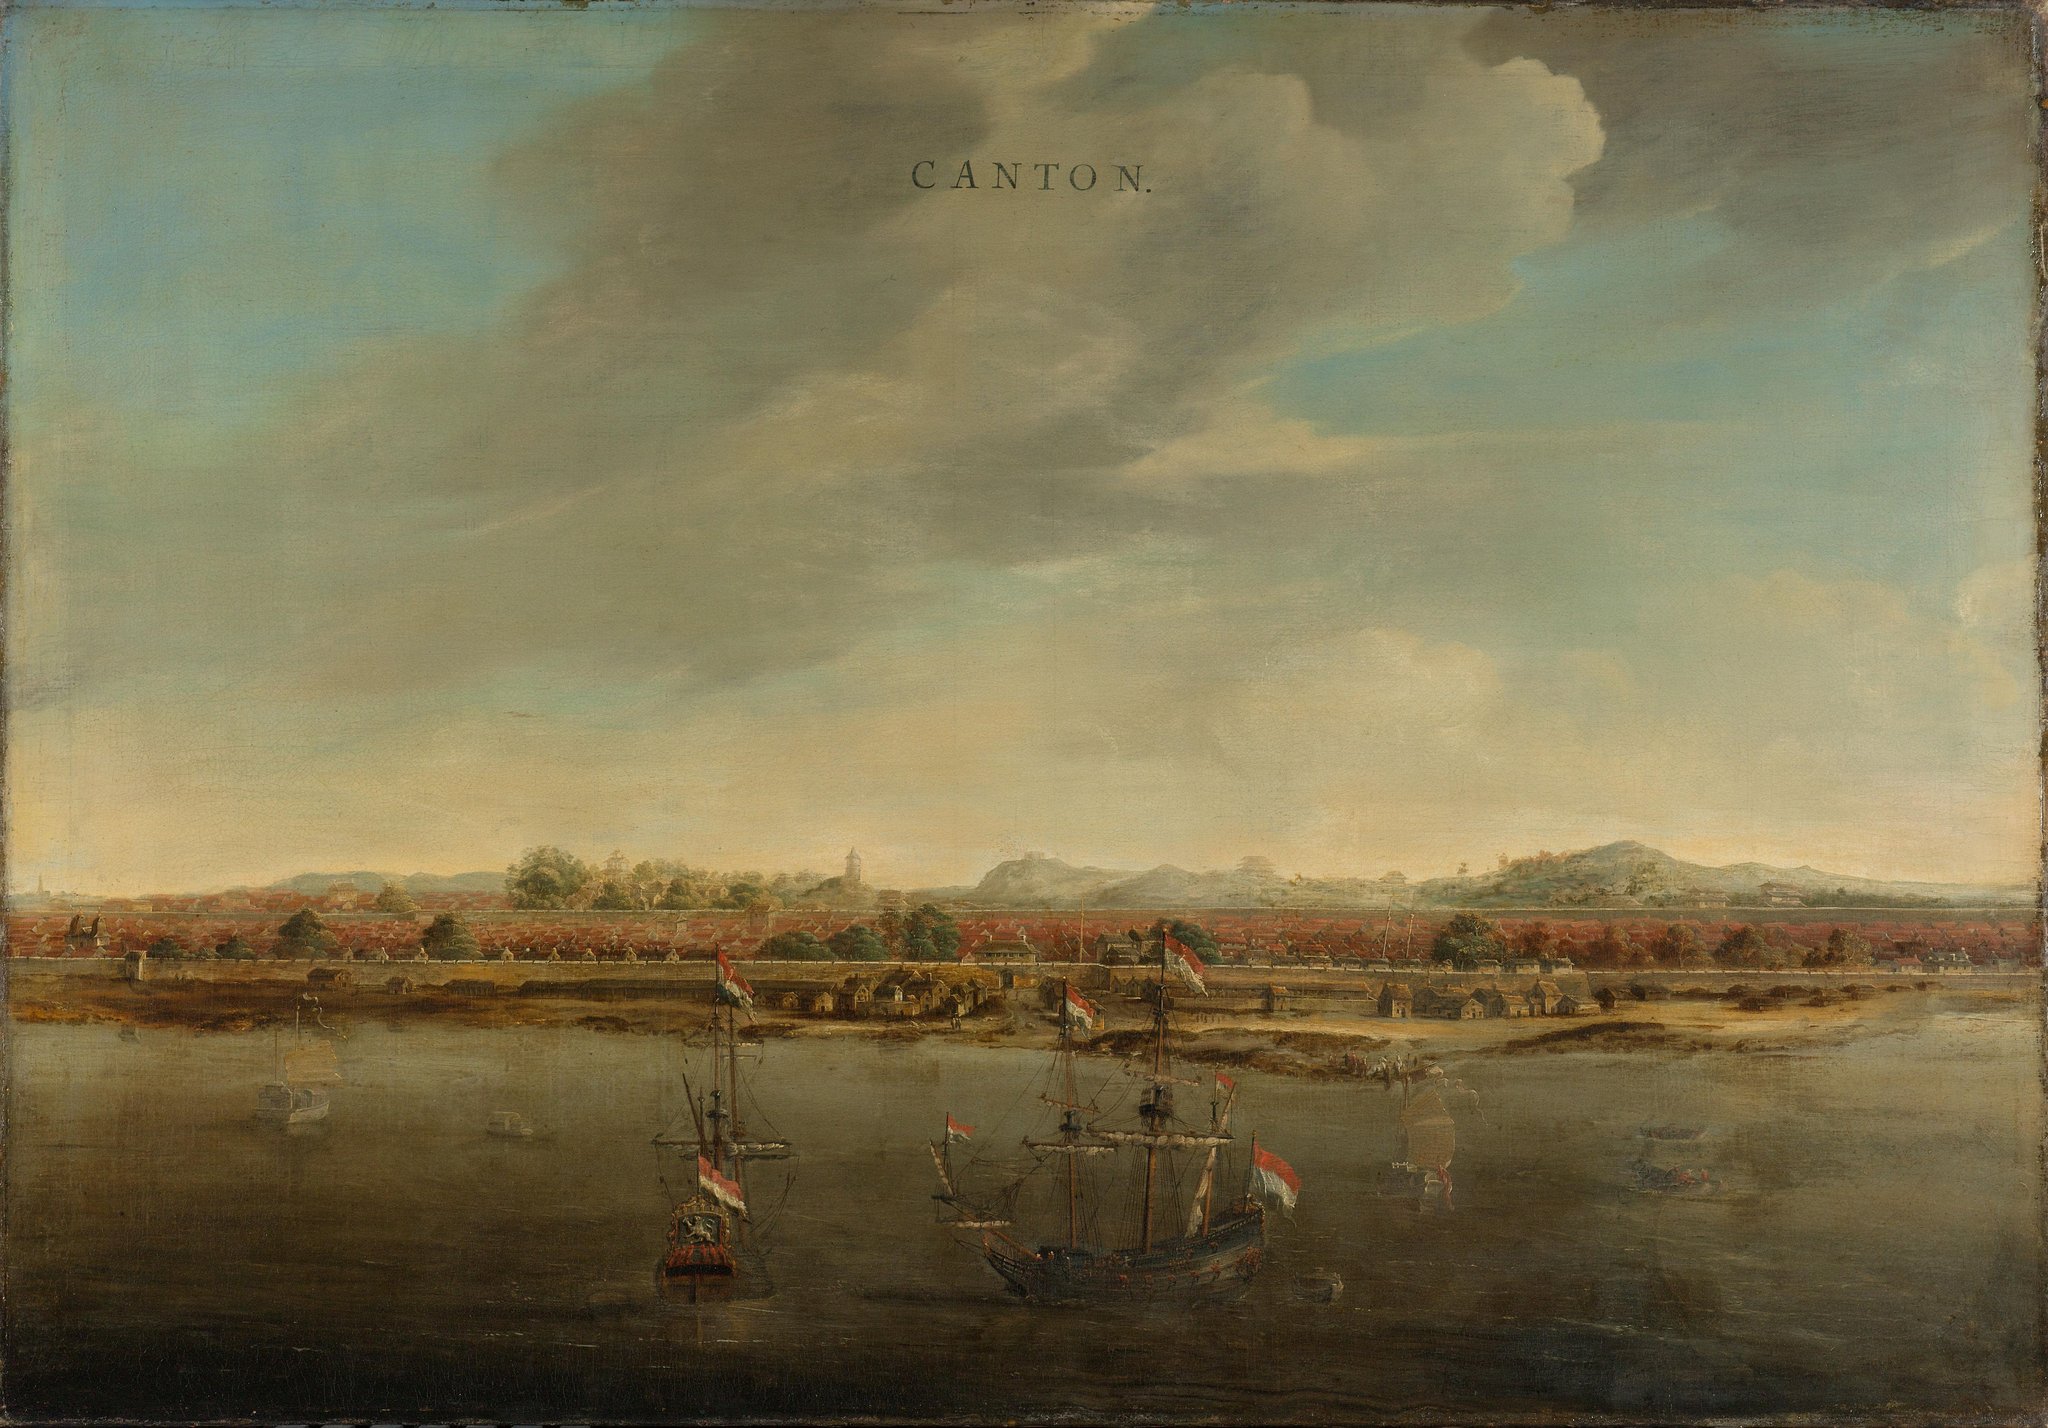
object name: painting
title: Trading posts of the Dutch East India Company (VOC)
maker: johannes vinckboons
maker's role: draughtsman, print maker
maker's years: 1616-1670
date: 1662-1663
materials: linen, oil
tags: sailing-ship, sailing-boat, locations for trading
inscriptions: inscription: ‘Canton.’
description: This series of paintings hanging high in a row here feature various trading posts of the Dutch East India Company (VOC) in Asia. It was a network between which not only products but also enslaved people were transported. The VOC shipped between 660,000 and 1,135,000 people in the 17th and 18th centuries.